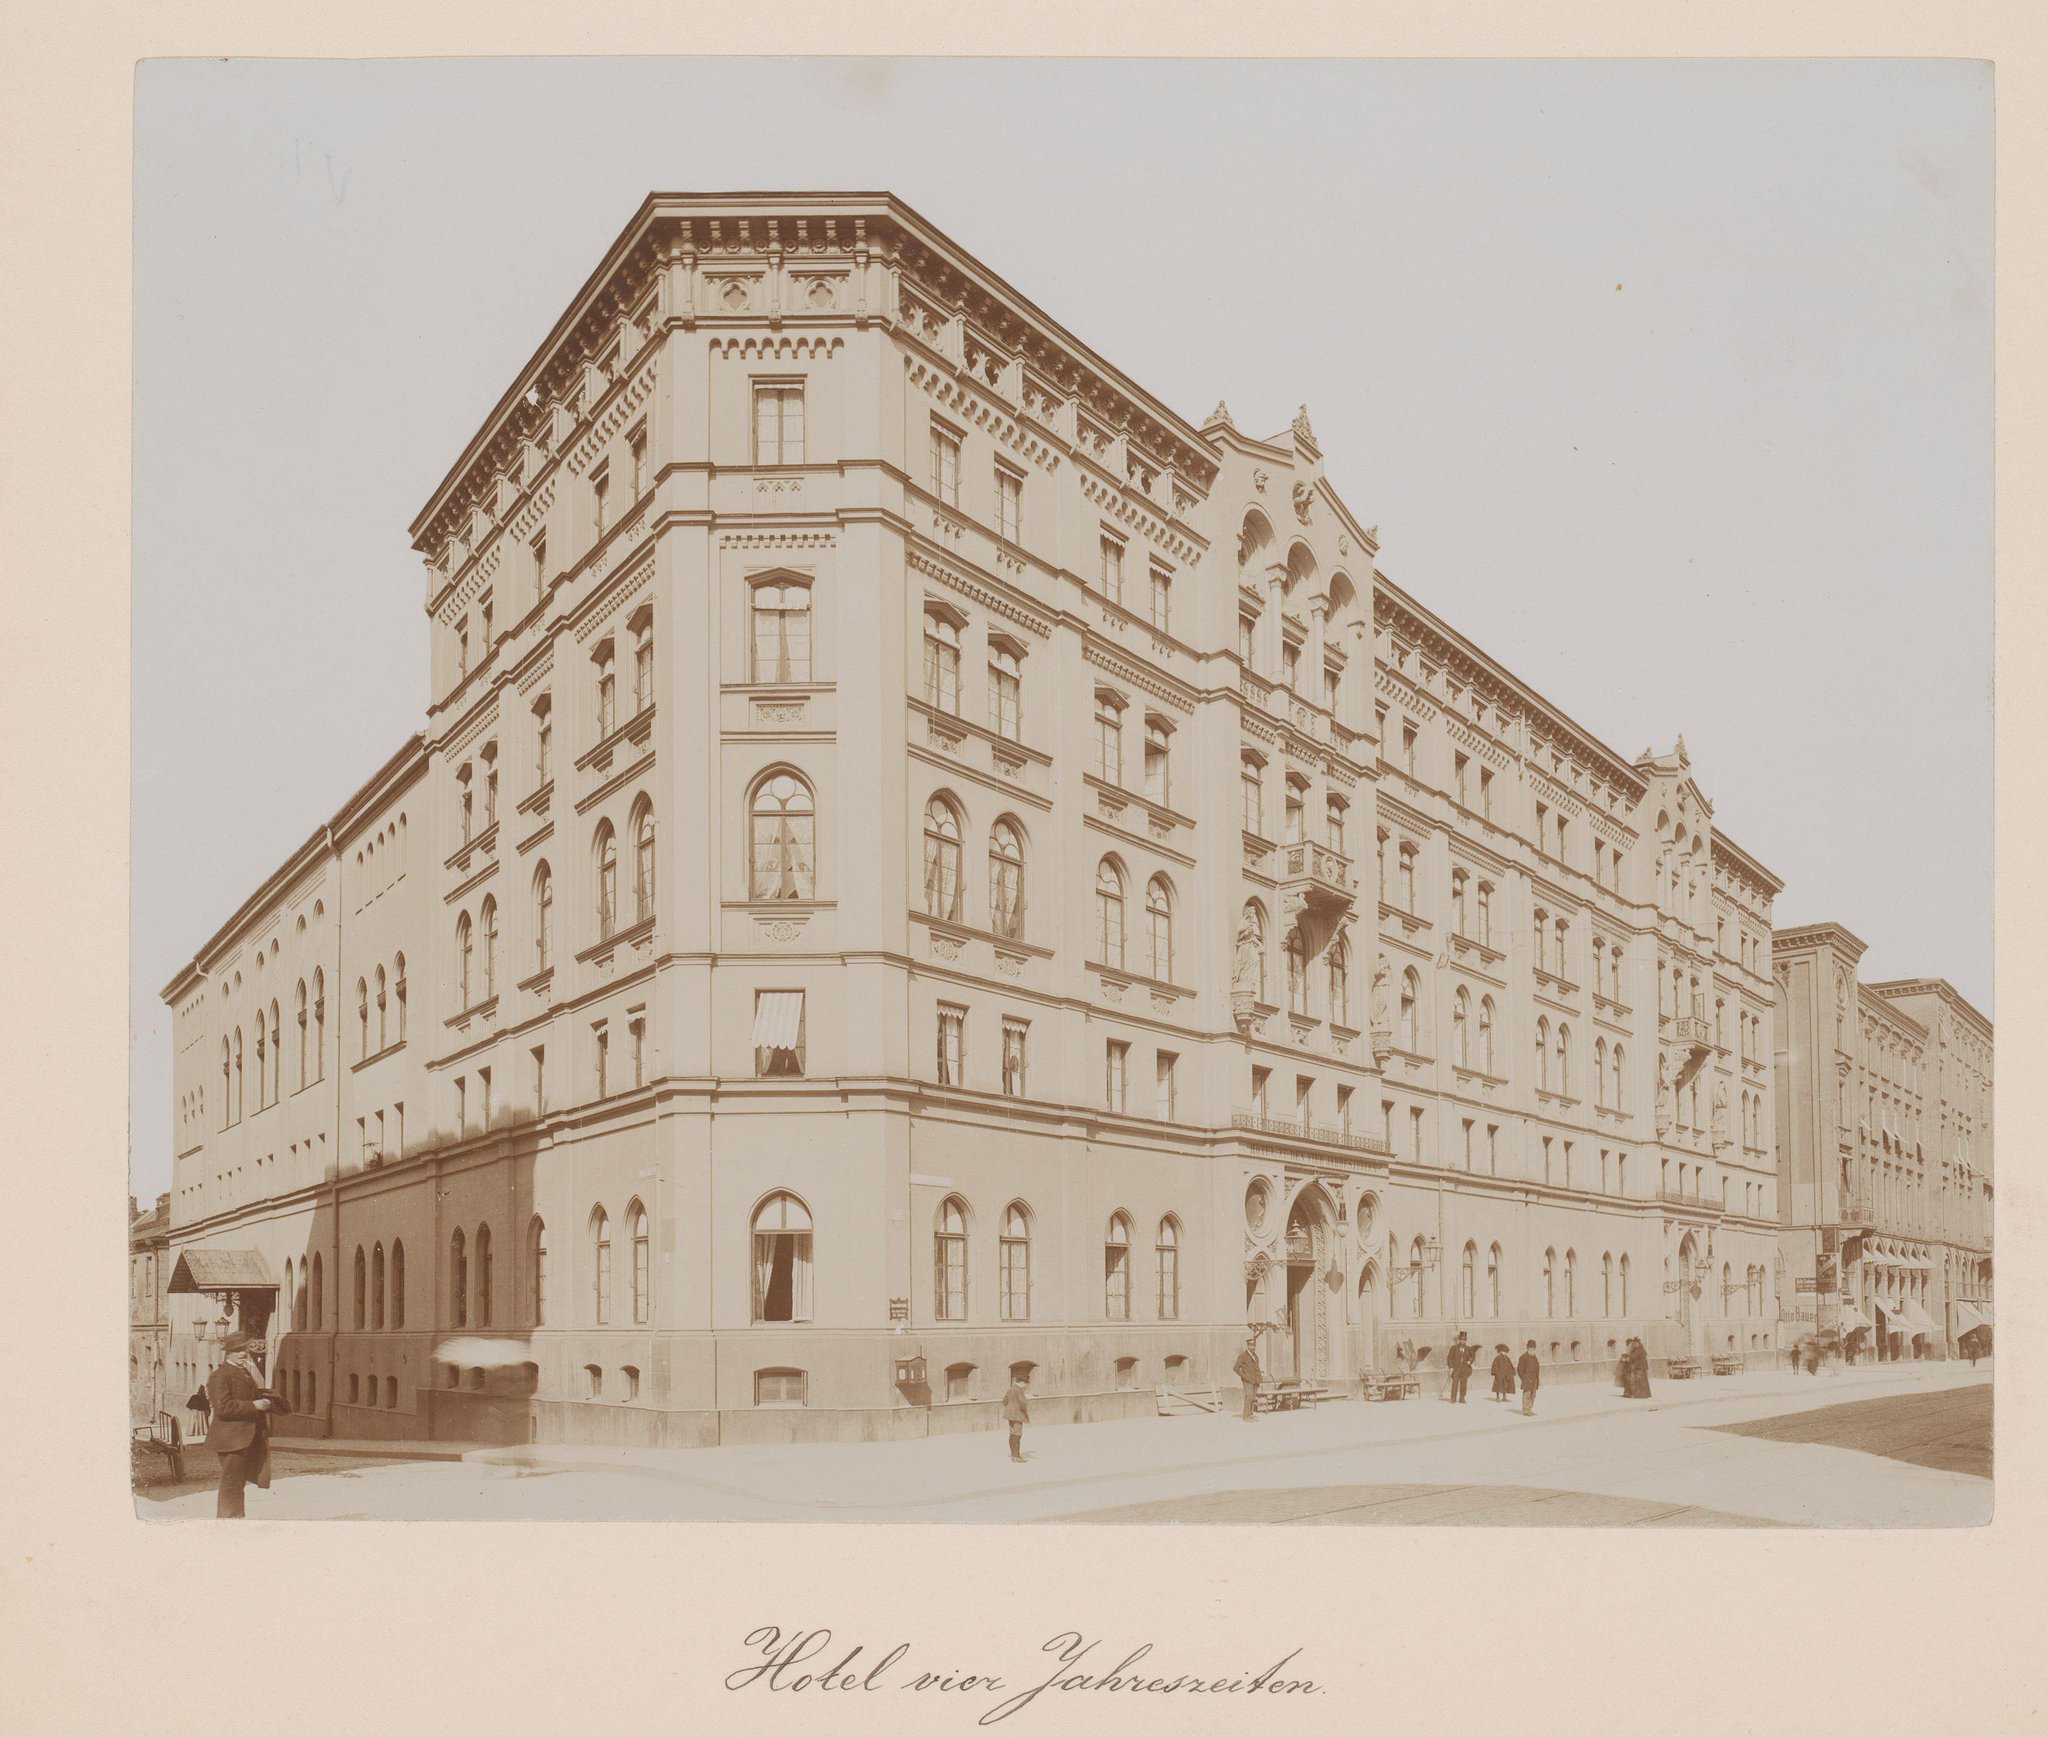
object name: photograph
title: Hotel Vier Jahreszeiten, München, Duitsland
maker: Anonymous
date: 1880-1910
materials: cardboard, photographic support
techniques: collodion silver print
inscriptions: inscription: ‘Hotel vier Jahreszeiten.’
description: Aanzicht op het zeer luxe hotel dat werd gebouwd naar ontwerpen van de Duitse architect Rudolf Gottgetreu tussen 1856-1858. Geopend 25 juli 1858.